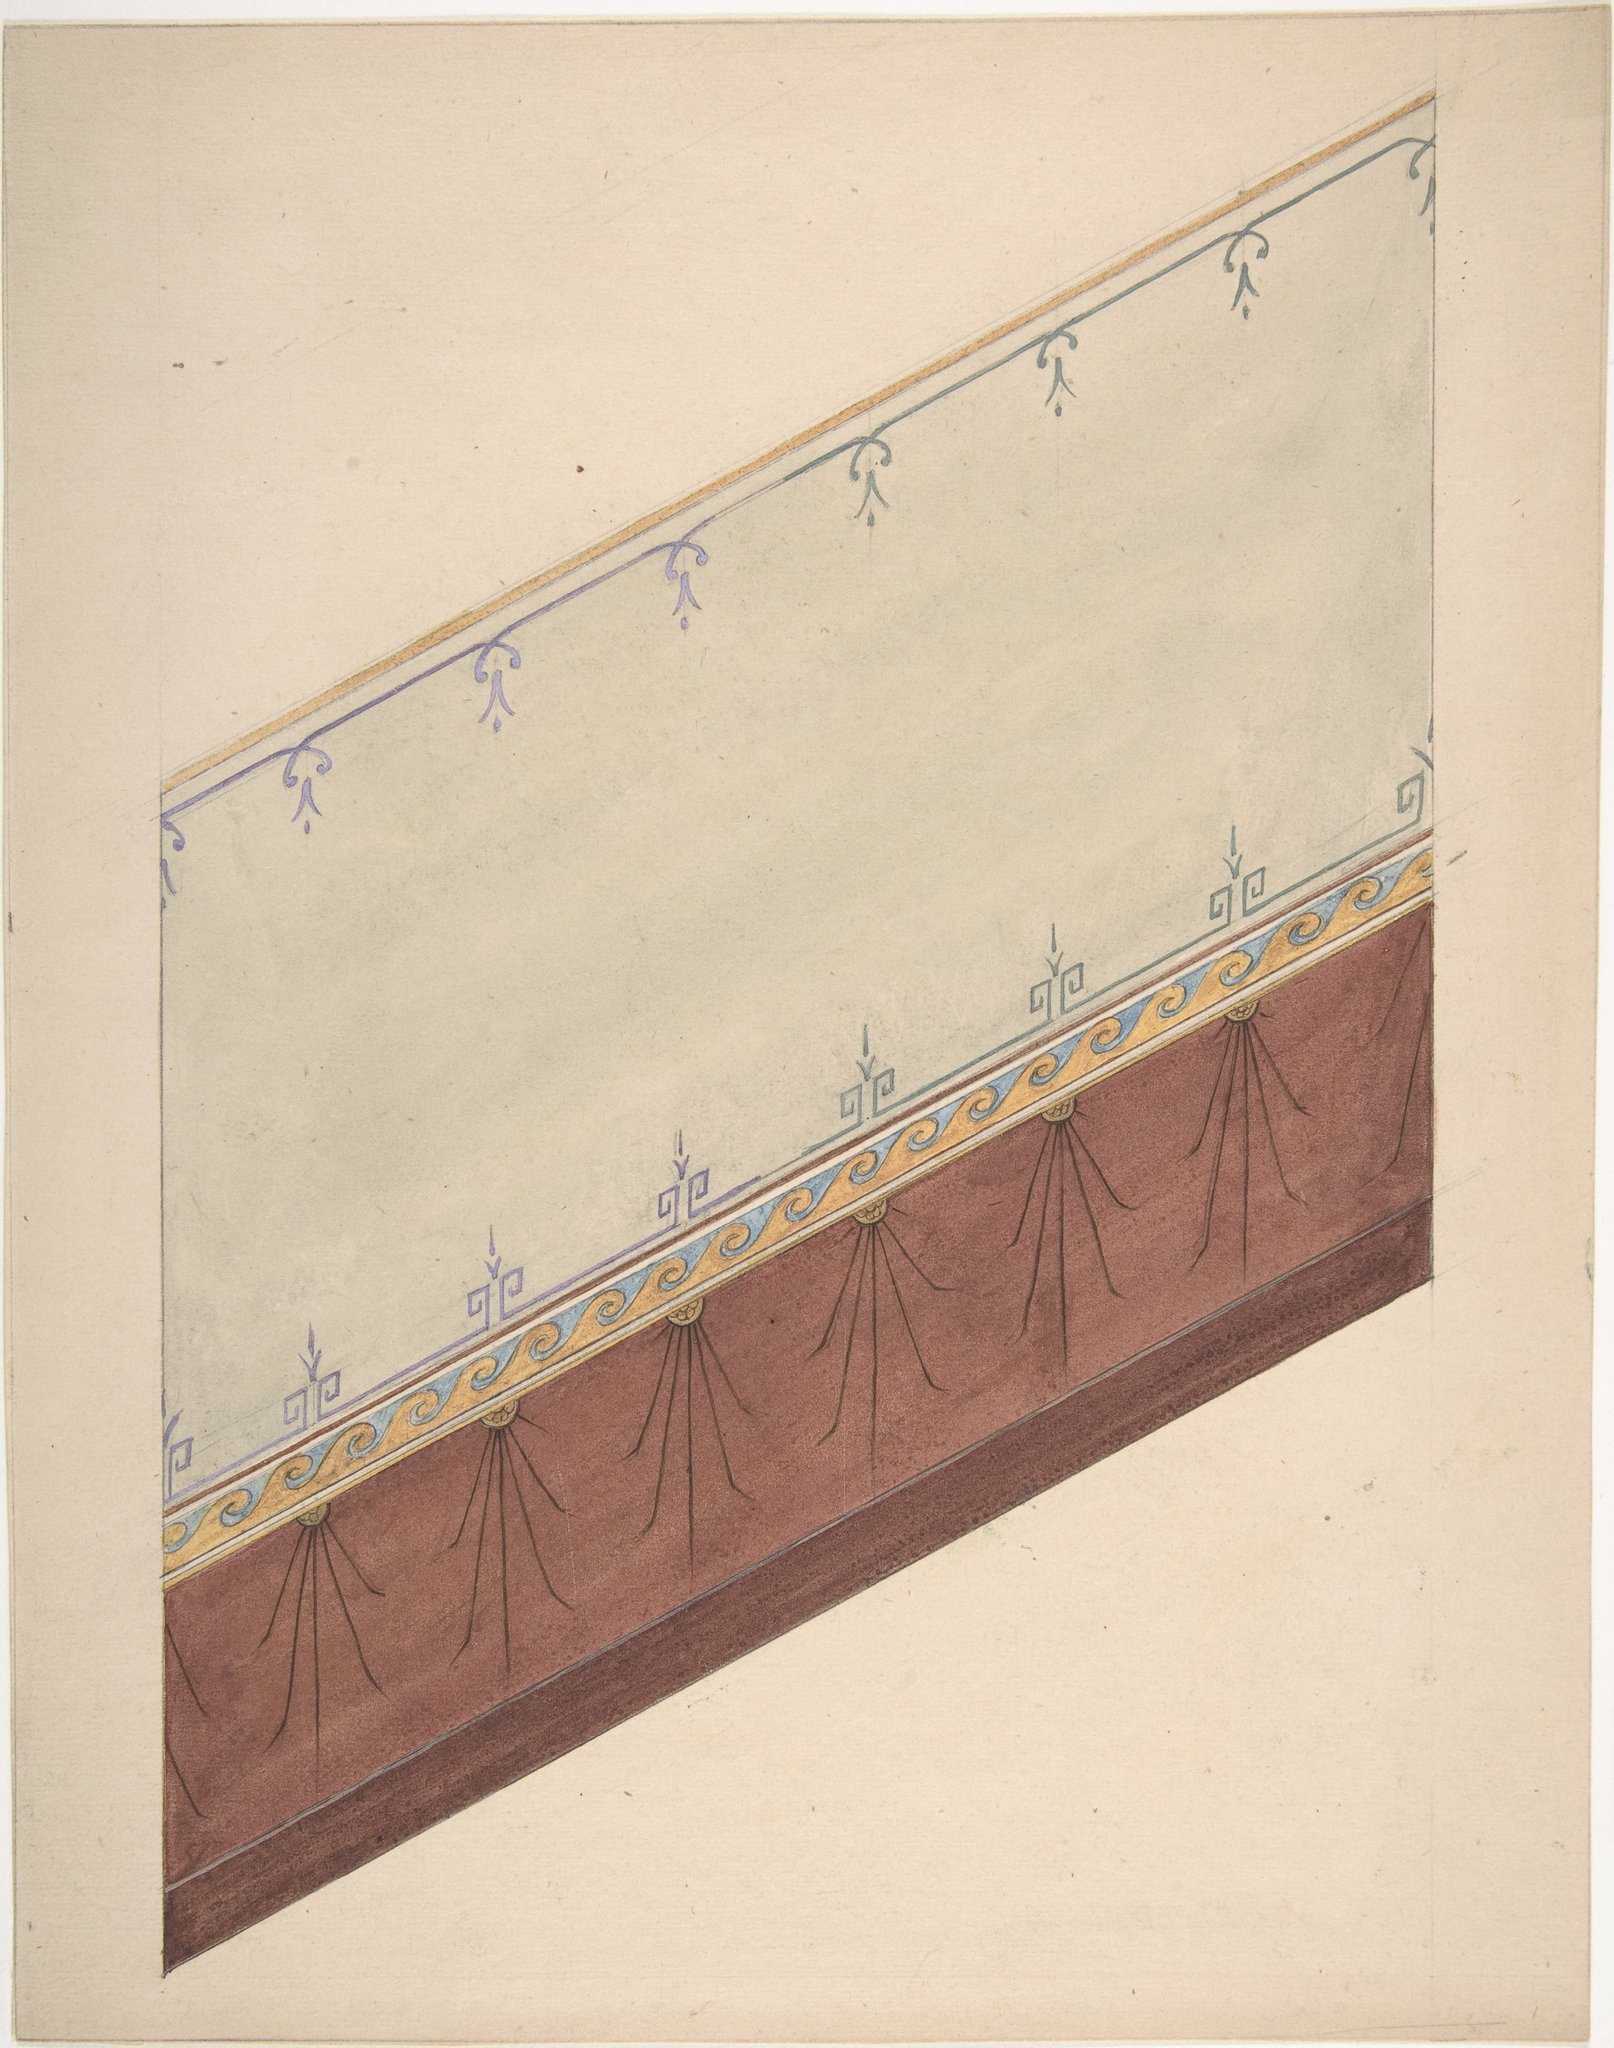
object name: drawing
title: Pompeiian Design for Paneling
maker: jules-edmond-charles lachaise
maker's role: artist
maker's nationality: french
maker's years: 1897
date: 1851-1900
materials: graphite, ink, watercolor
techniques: pen